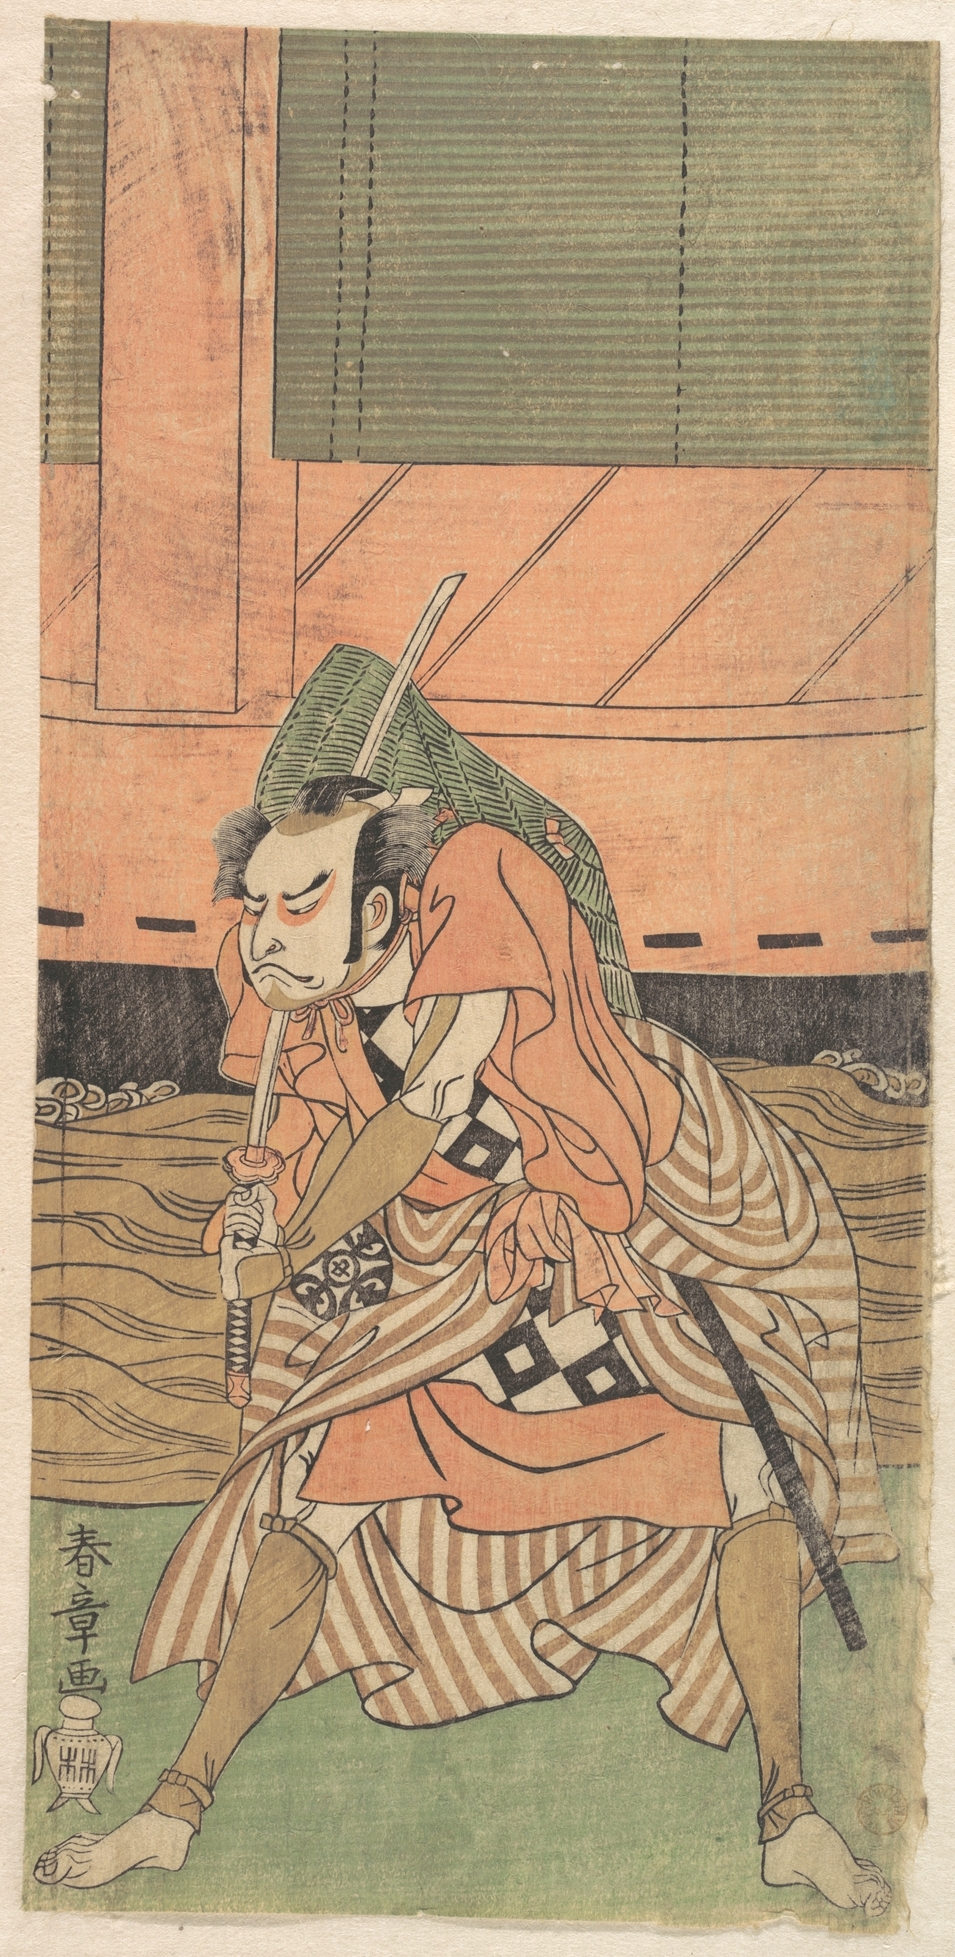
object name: woodblock print nishiki e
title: The First Nakamura Nakazo as a Samurai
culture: japanese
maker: katsukawa shunshō 勝川春章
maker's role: artist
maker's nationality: japanese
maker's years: 1726-1792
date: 1770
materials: ink, paper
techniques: nishiki e, woodblock print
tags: swords,men